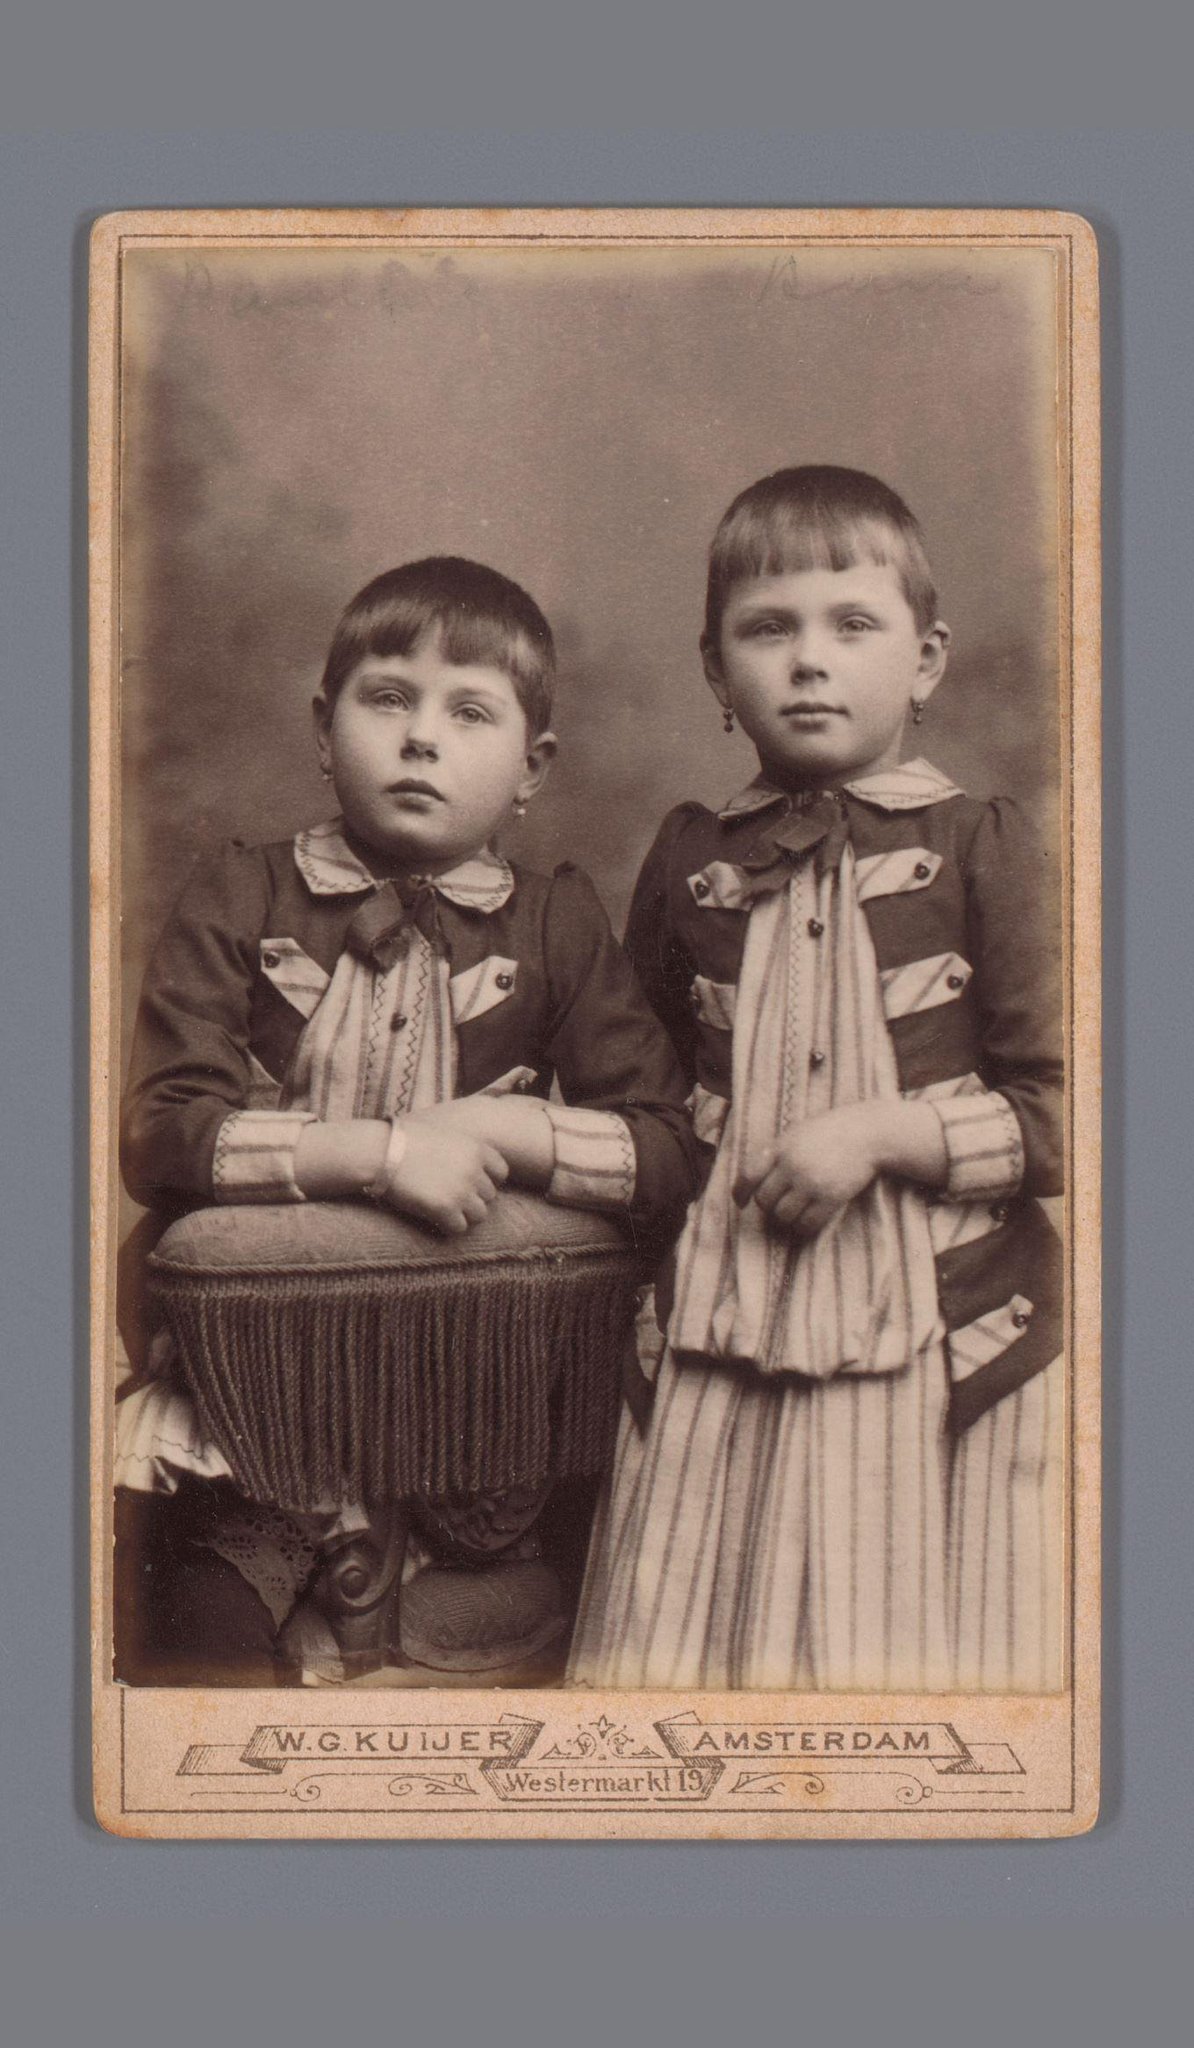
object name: carte de visite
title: Portret van Annie en Pauline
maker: willem gerhardus kuijer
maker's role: fotograaf, hoffotograaf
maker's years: 1834-1899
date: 1885-1906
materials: cardboard, photographic support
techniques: collodion silver print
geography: amsterdam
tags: historical persons - bb - woman, amsterdam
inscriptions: annotation: ‘Pauline Annie’, workshop stamp: ‘Amsterdam/ W.G. Kuijer/ Westermarkt 19’